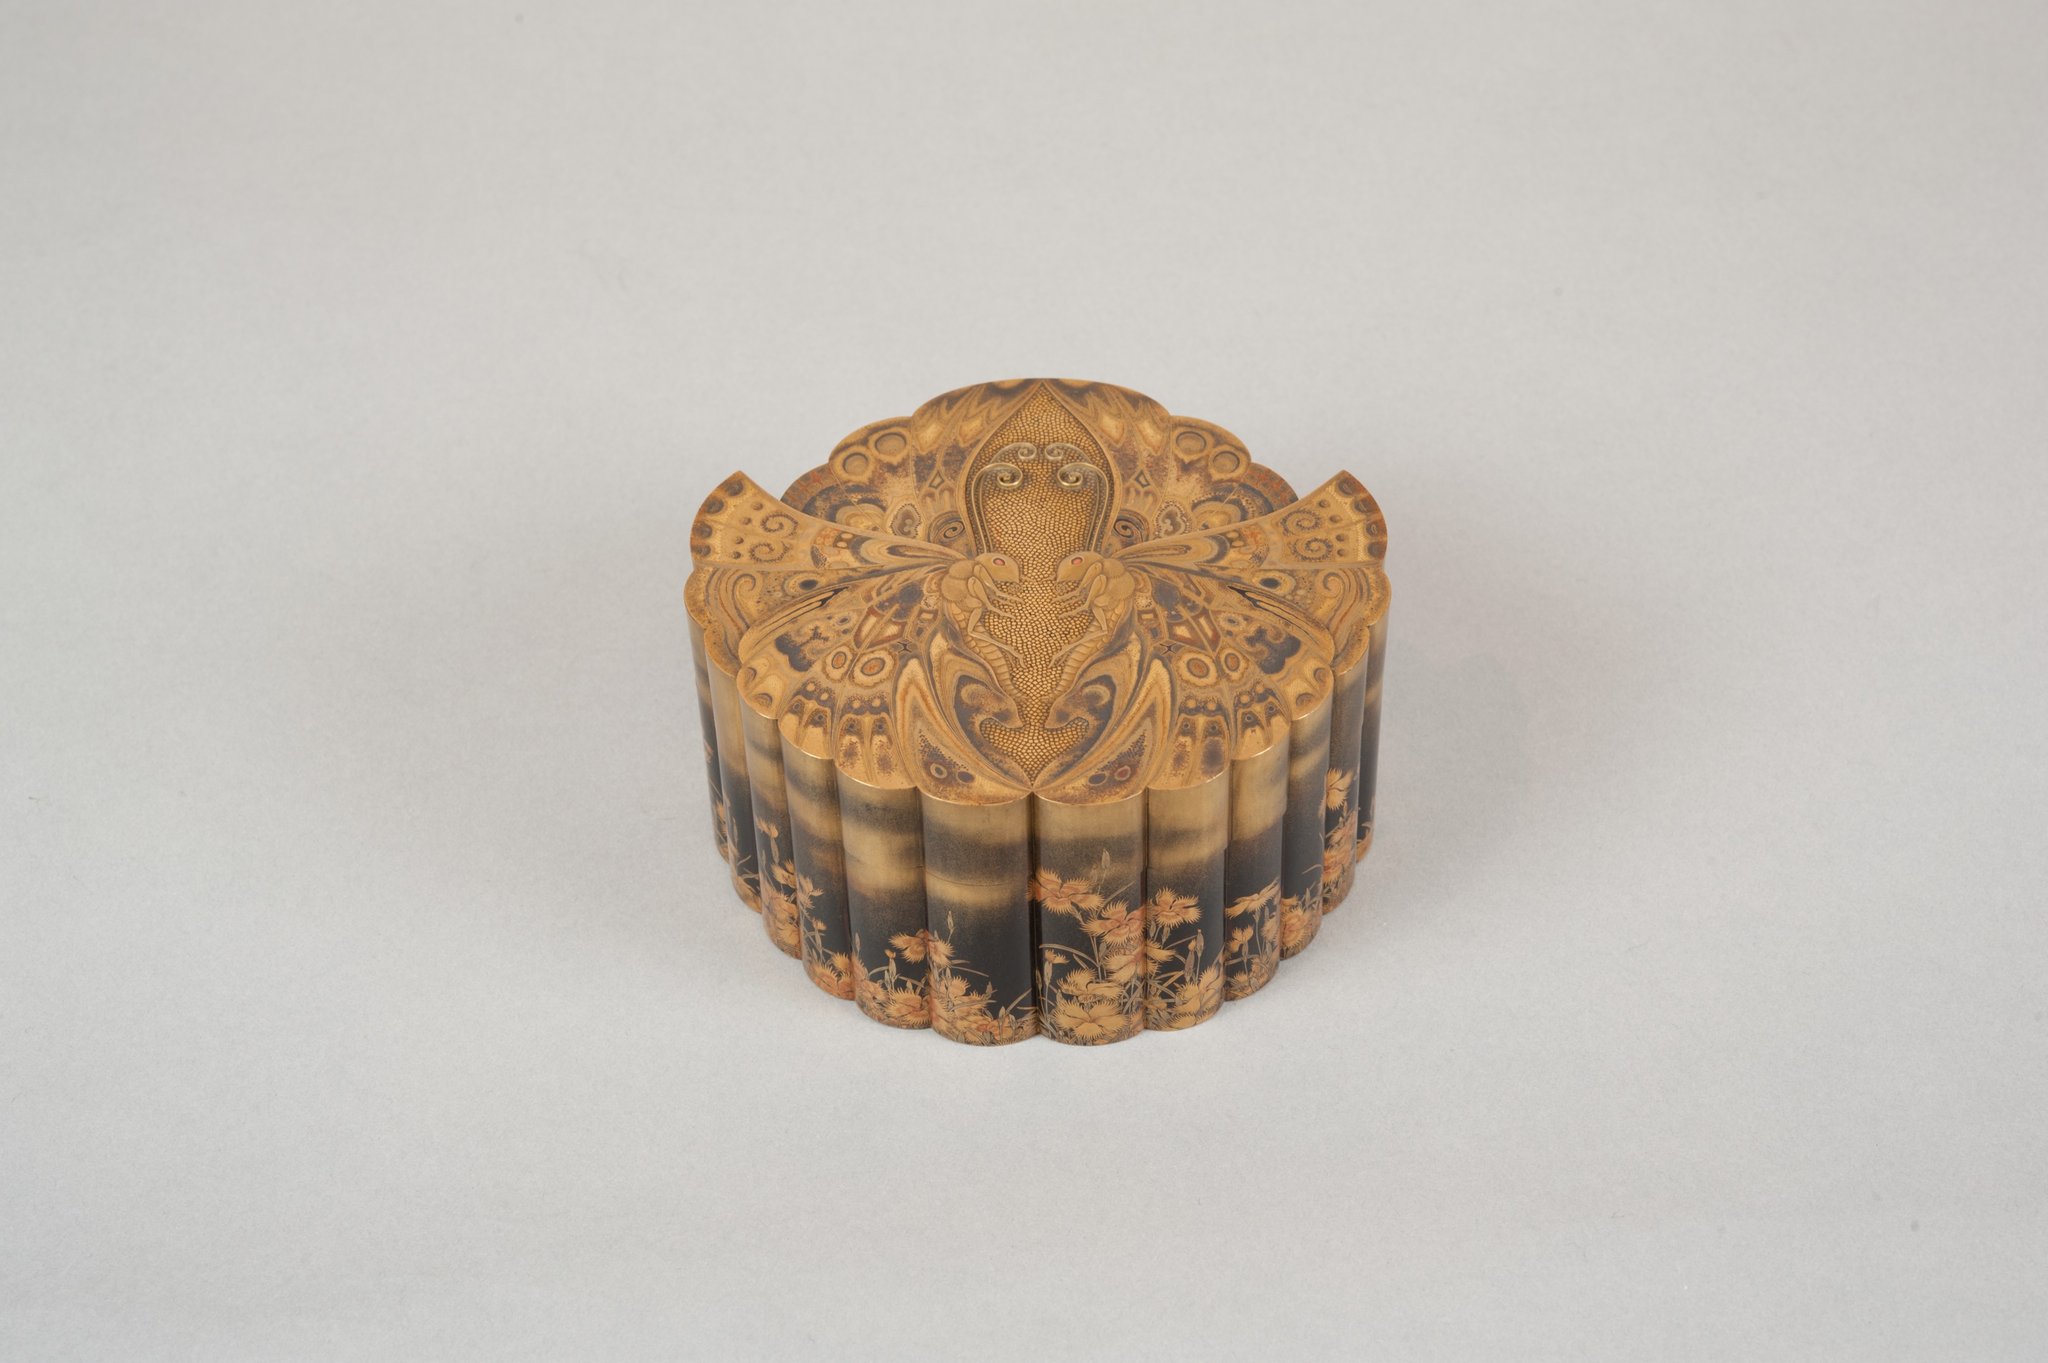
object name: box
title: Box in Shape of Butterfly with Design of Wild Pinks on Side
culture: japanese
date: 1801-1900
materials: gold, lacquer, mother of pearl, silver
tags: butterflies,flowers